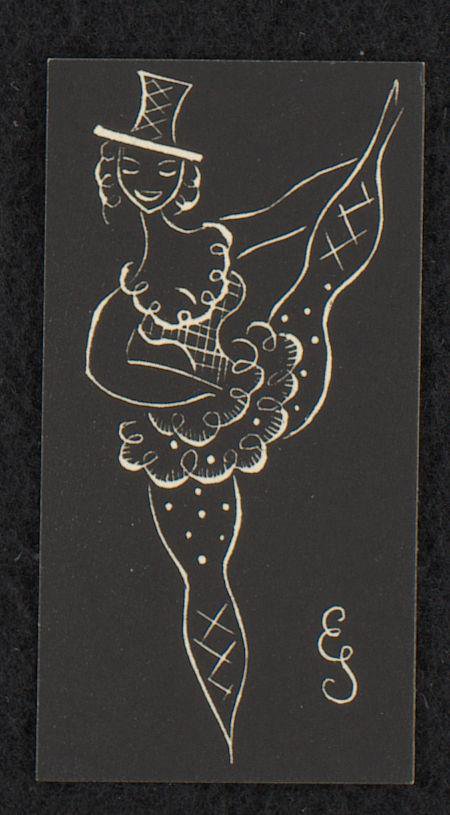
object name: print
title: Ex libris van Eugène Strens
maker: Anonymous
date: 1909-1980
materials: paper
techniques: woodcut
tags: eugène louis charles marie strens, ex-libris